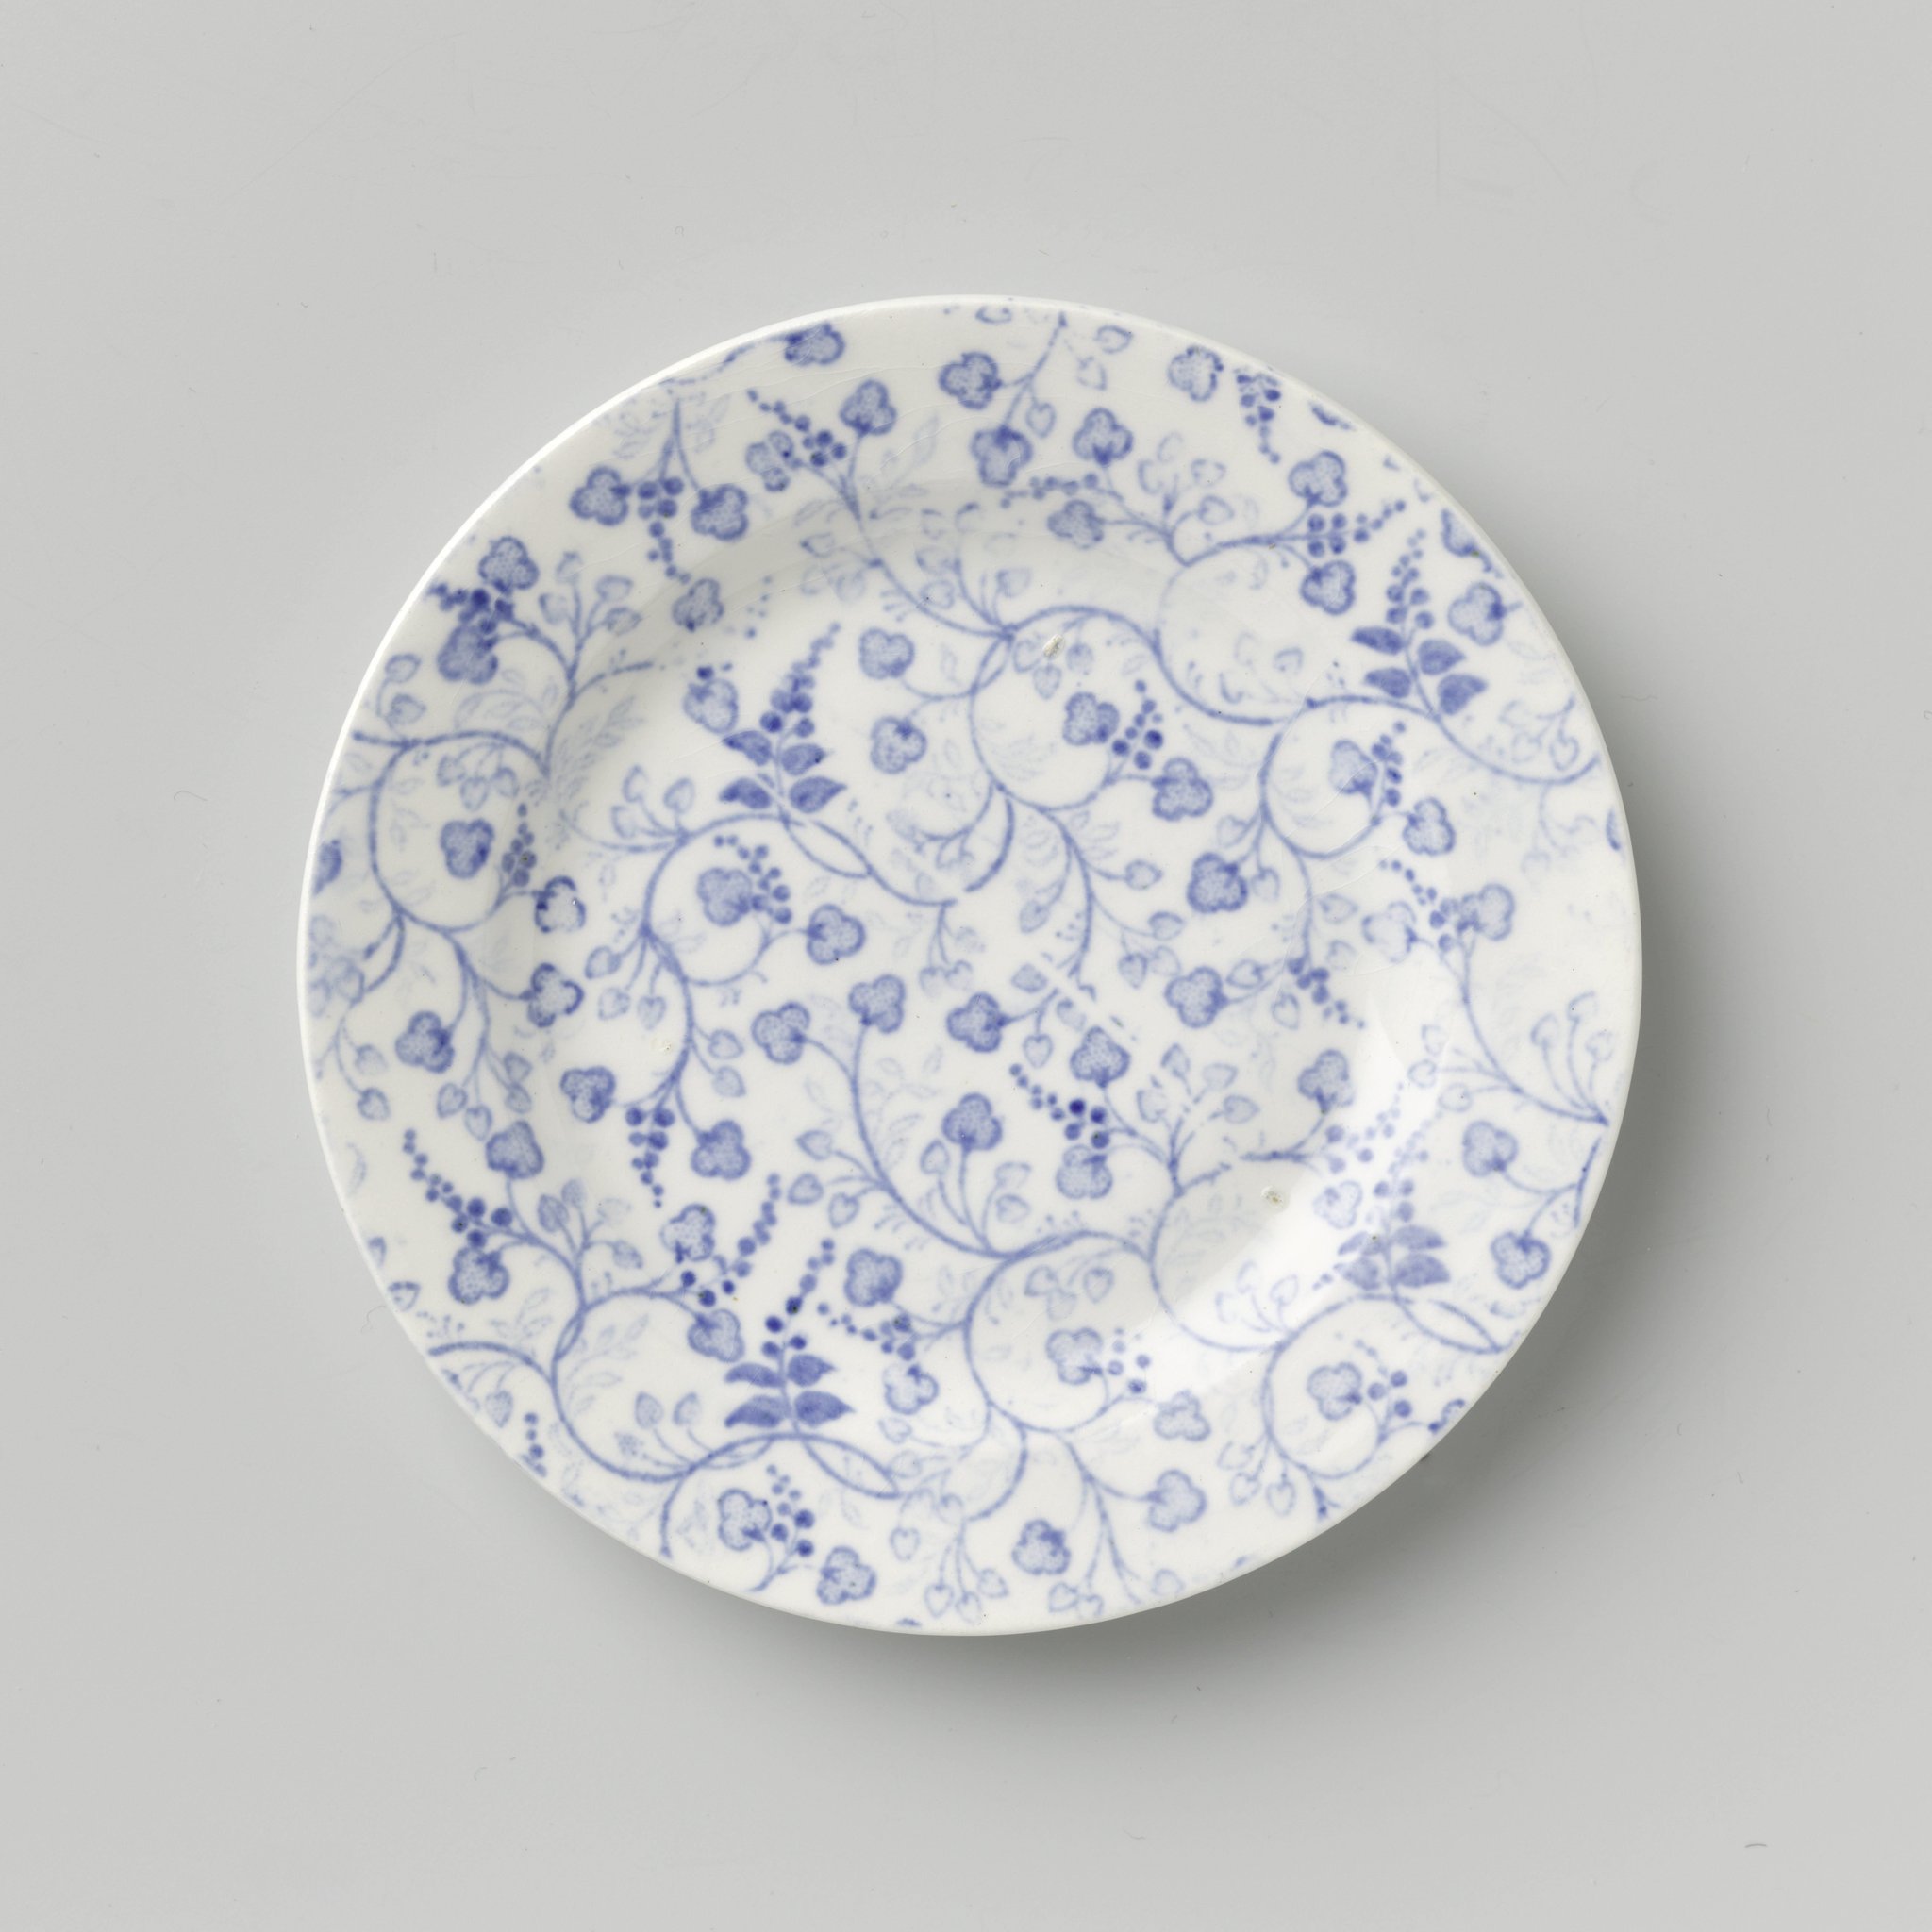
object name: plate dish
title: Bord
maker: petrus regout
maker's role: plateelbakker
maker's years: 1801-1879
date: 1867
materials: creamware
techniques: transfer decoration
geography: maastricht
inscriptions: check stamp: ‘PR // 29’, mark: ‘PARSEME No 3’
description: Bord van aardewerk, met blauw doorlopend bloemendecor, behorend tot een kinderservies.